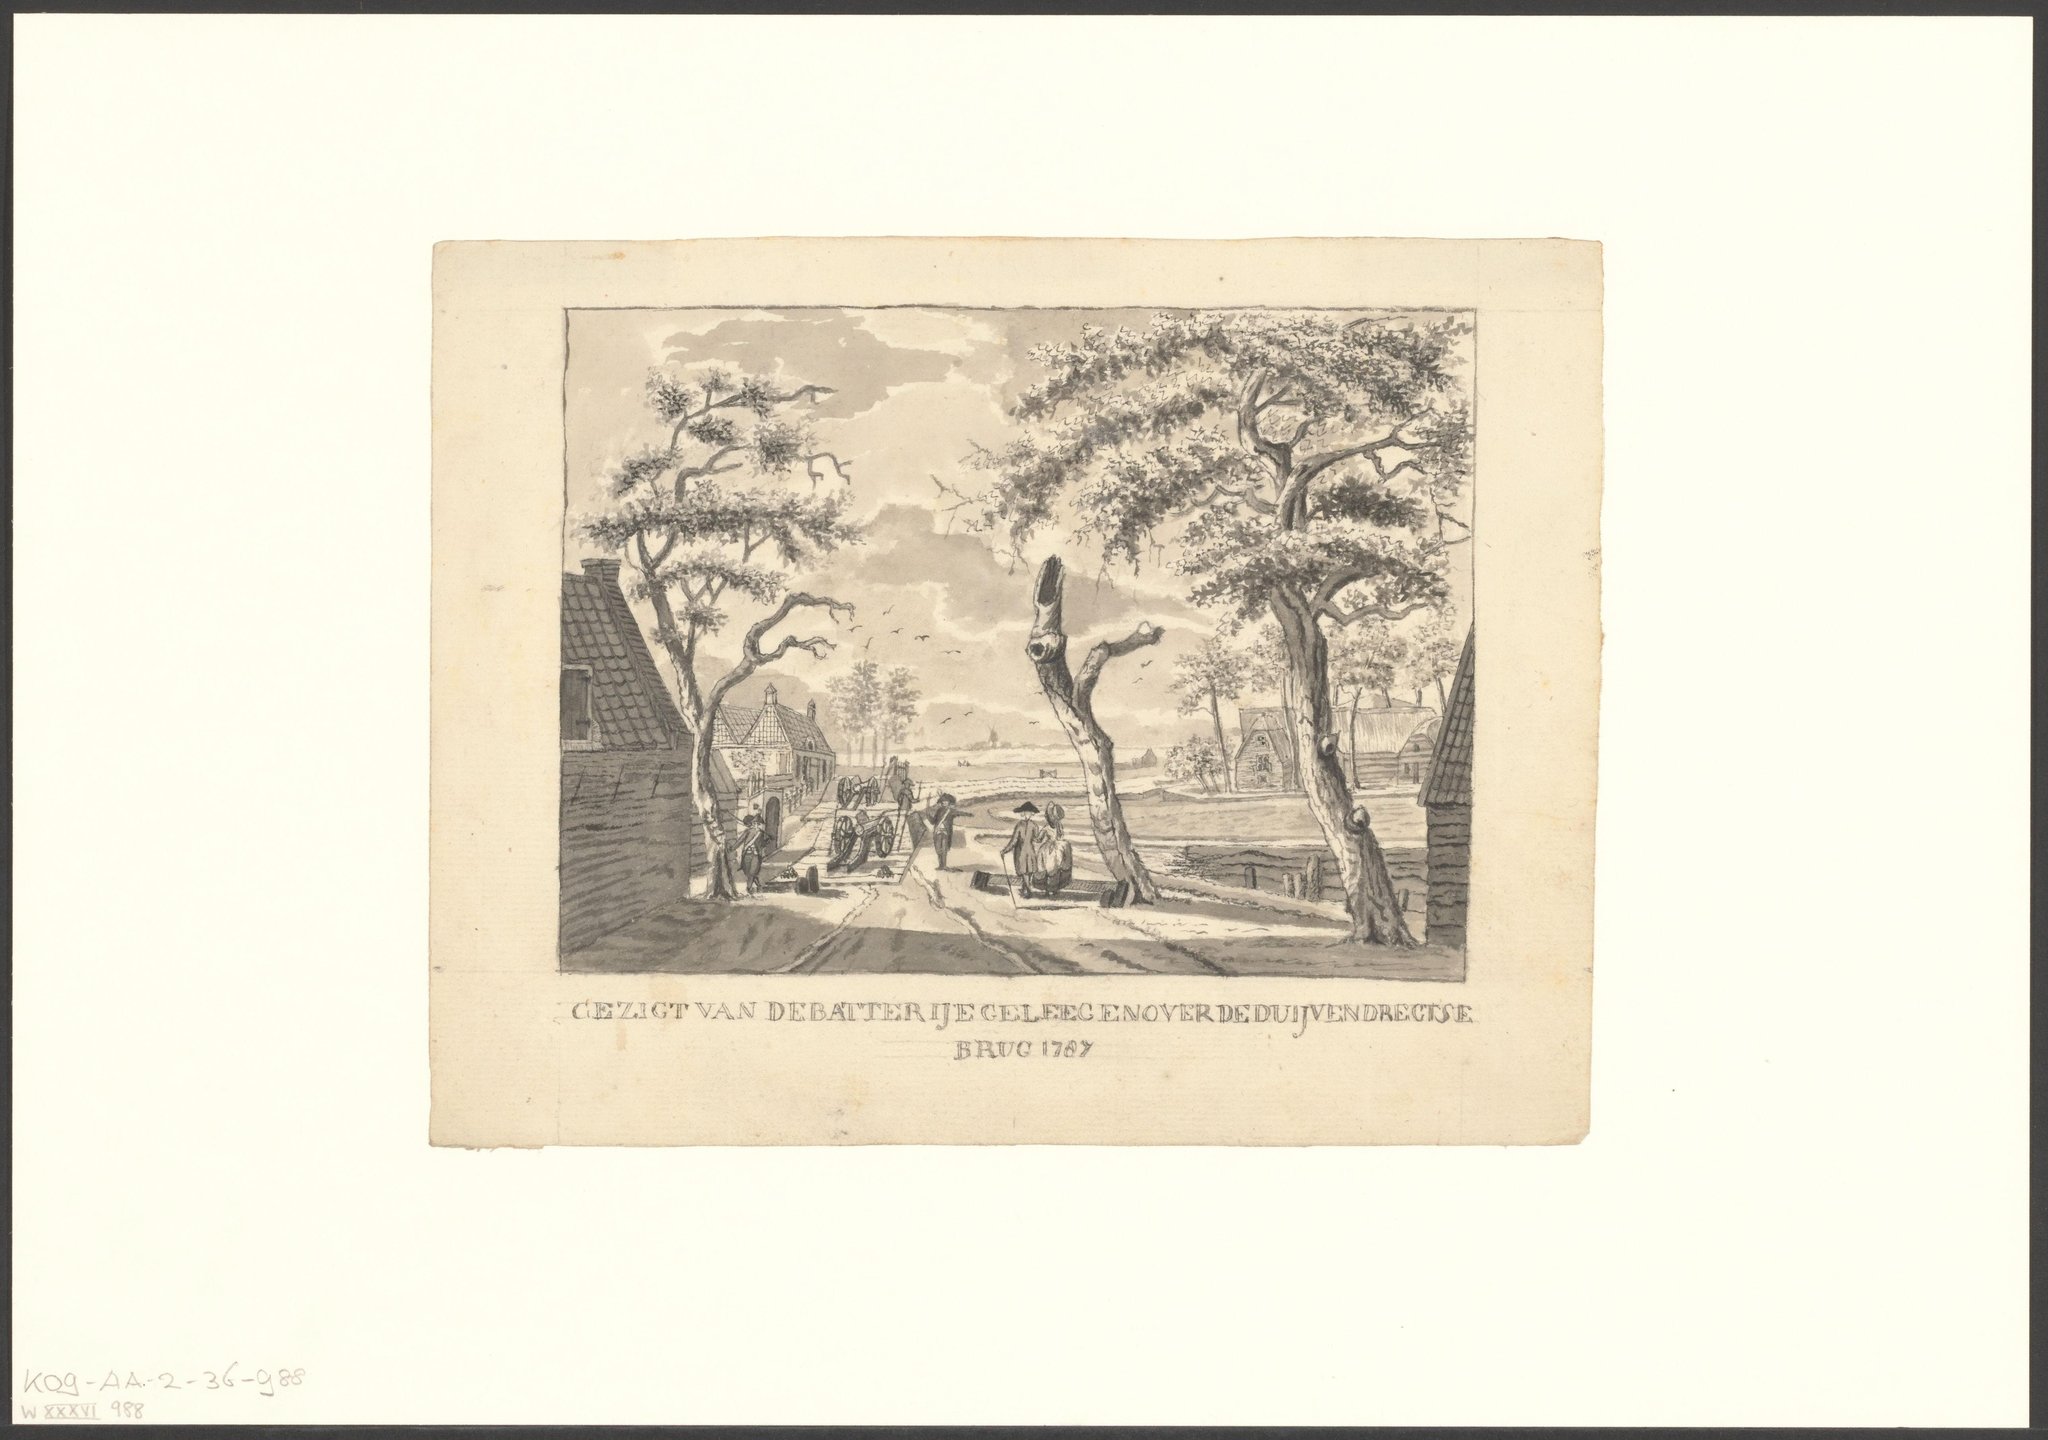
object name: drawing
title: Batterijen rondom Amsterdam in 1787 (getekende kopieën)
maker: Anonymous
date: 1787-1899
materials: ink, paper, pencil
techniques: brush, pen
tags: defence of fortification or city, defensive measures (military)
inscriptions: inscription: ‘Gezigt van de batterije geleegen over de Duijvendregtse / Brug 1787’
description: Tekening binnen de Atlas Van Eck ingedeeld op wijknummer 36.